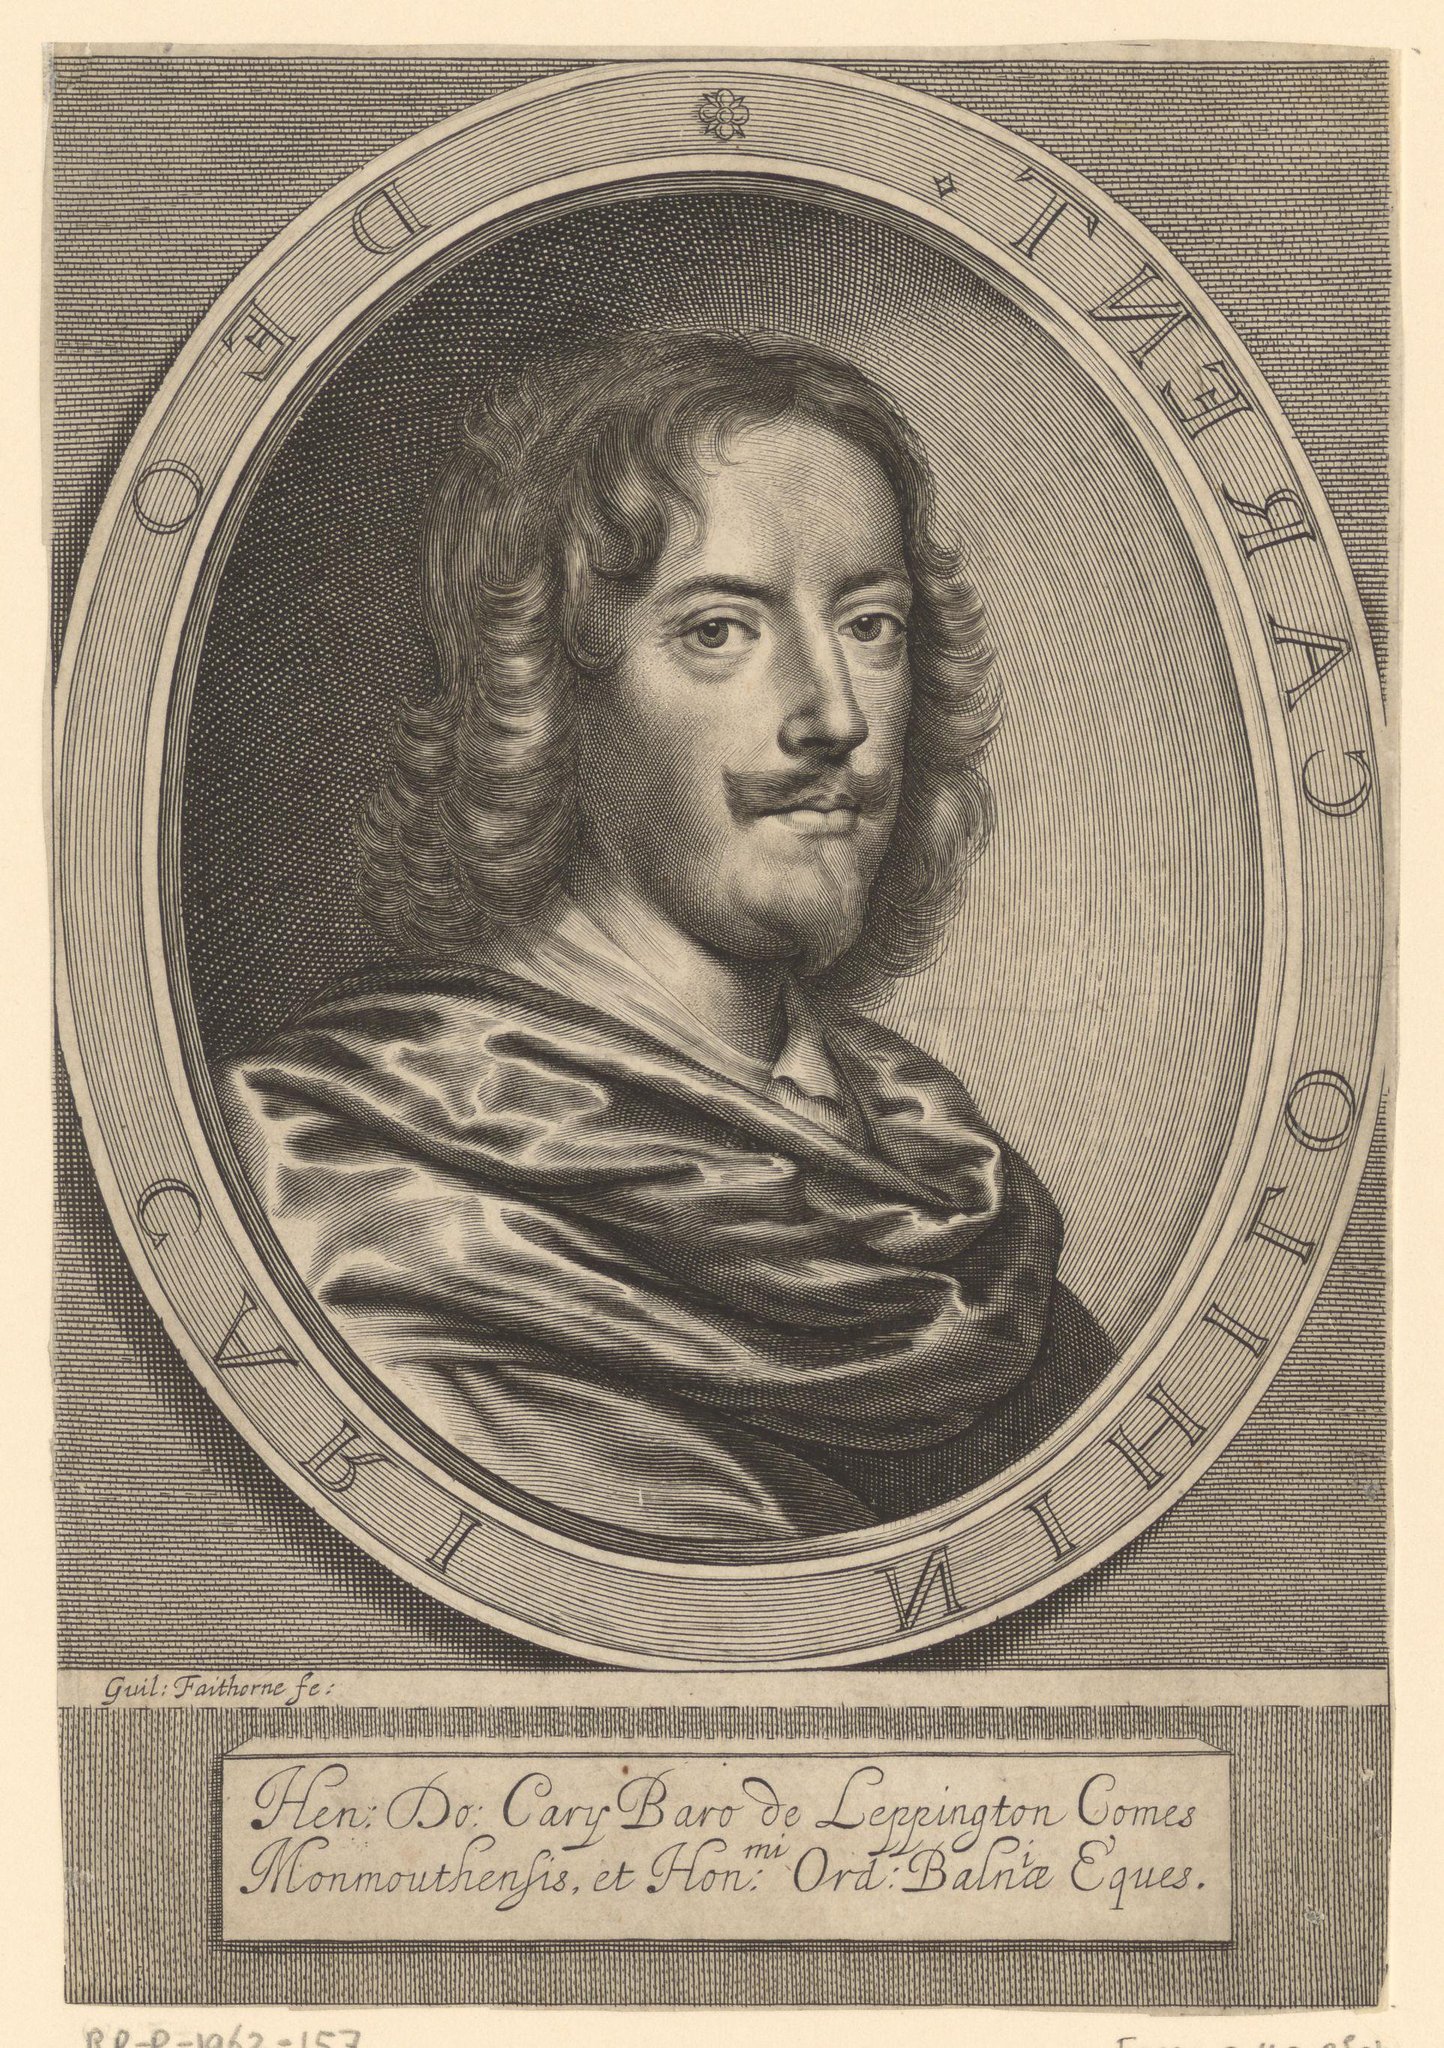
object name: print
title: Portret van Henry Carey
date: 1656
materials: paper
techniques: engraving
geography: london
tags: translator, historical persons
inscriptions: collector's mark: Lugt 2228, collector's mark: Lugt 2760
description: Prent uit: Bocalini, Trajano. I Ragguagli di Parnasso; or, Advertisements from Parnassus in two centuries. [Vertaald uit het Italiaans door] Henry Carey. Londen: Humphrey Moseley en Thomas Heath, 1656.